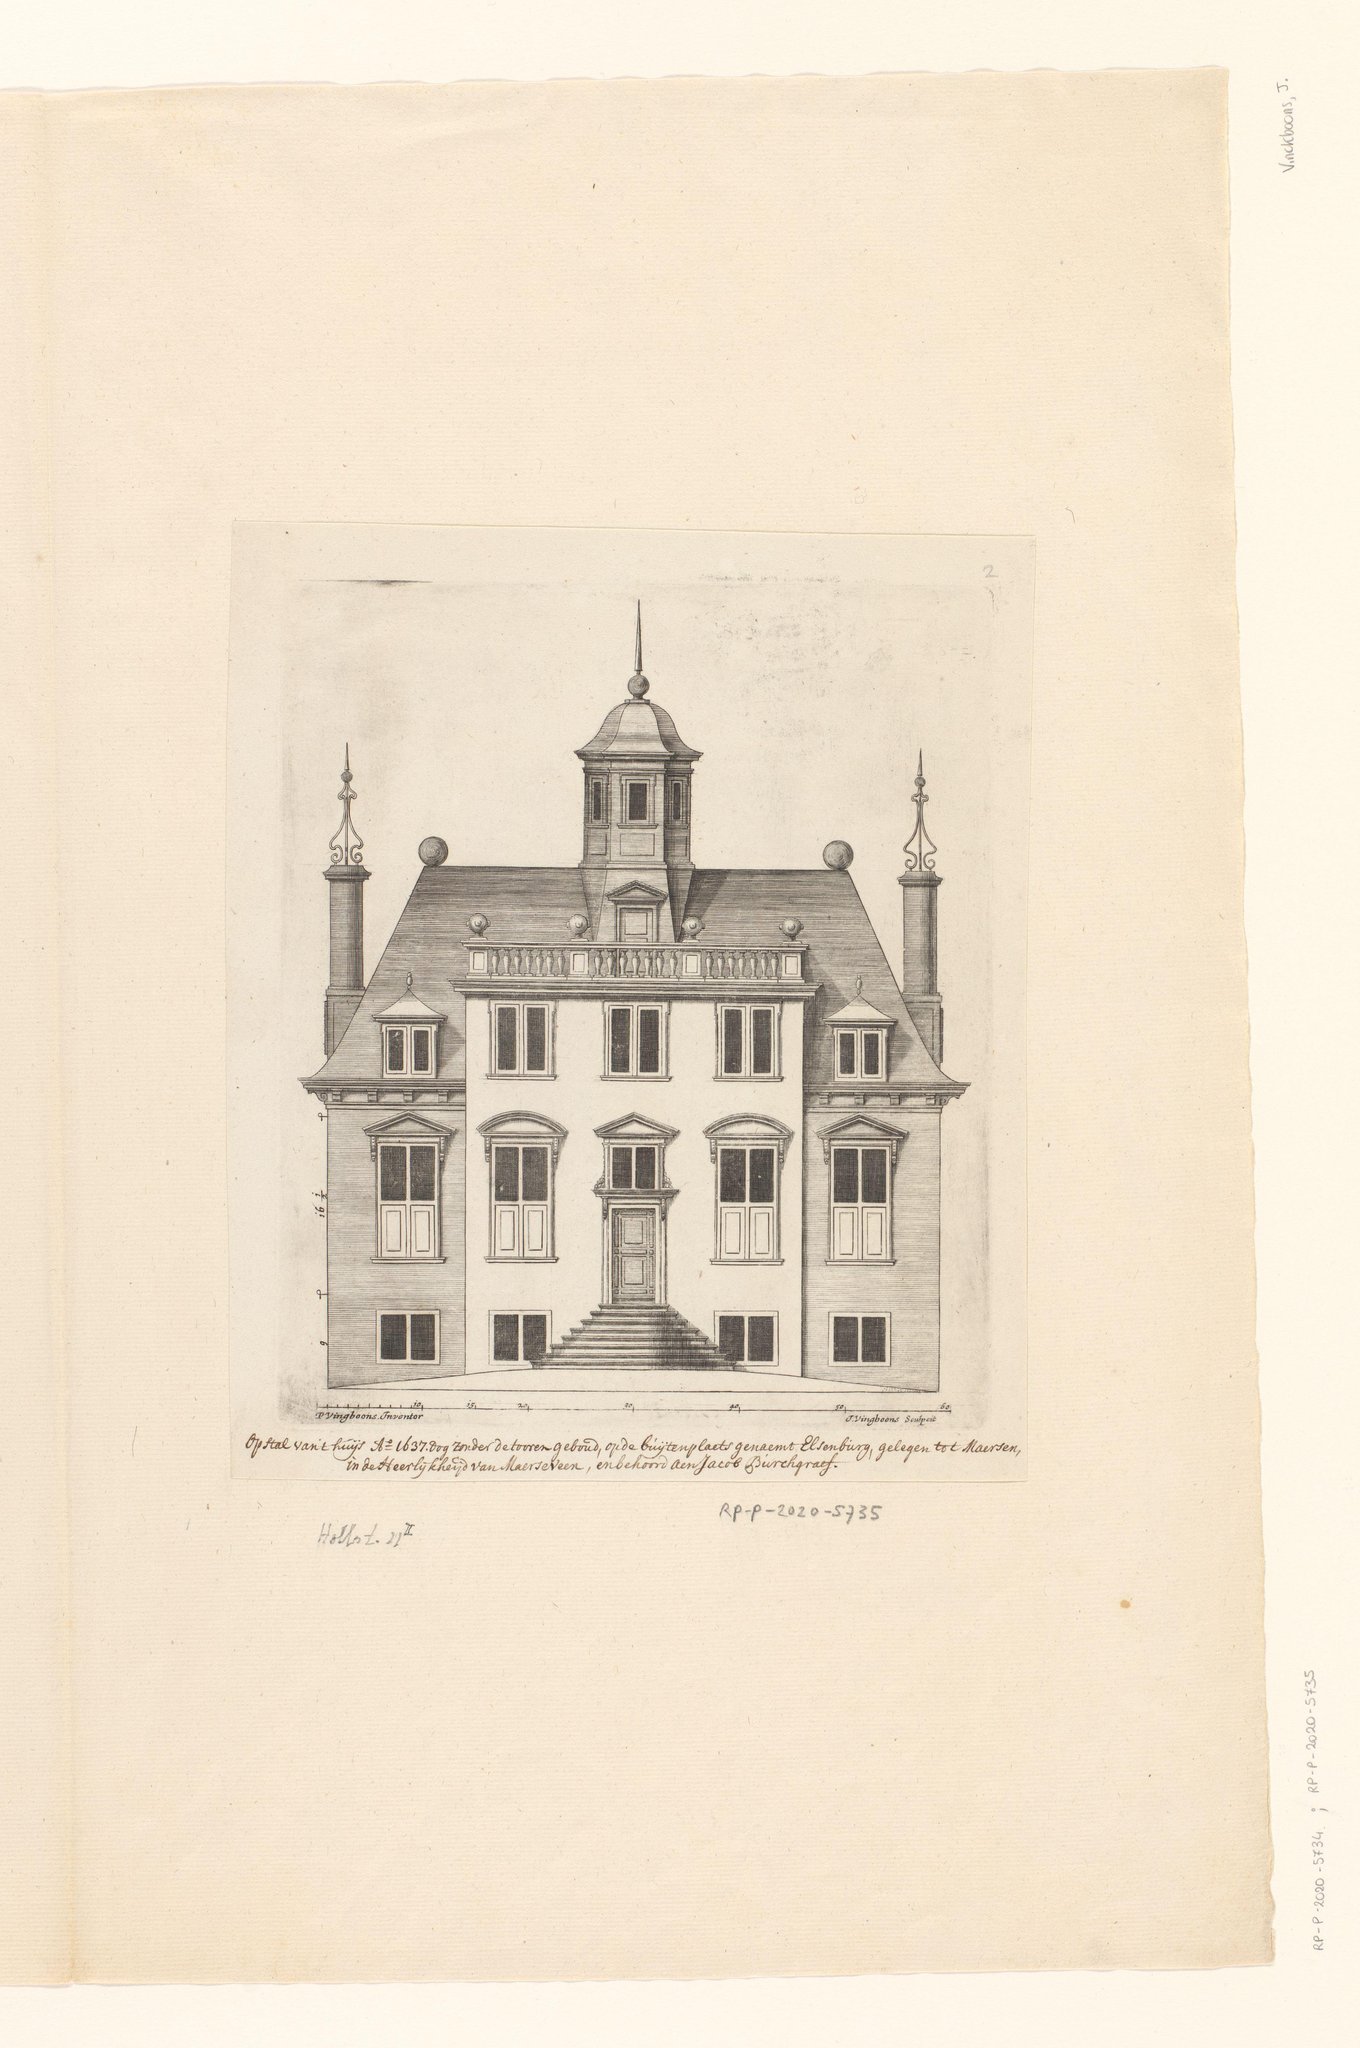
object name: print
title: Gevel van het landhuis Elsenburg te Maarsseveen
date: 1648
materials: paper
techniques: etching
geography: amsterdam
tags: country-house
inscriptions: inscription: ‘Opstal van 't huijs Ao. 1637. dog zonder de tooren geboud, op de buijtenplaets genaemt Elsenburg, gelegen tot Maersen,/ in de Heerlijkheijd van Maerseveen, en behoord aen Jacob Burchgraef.’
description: Prent waarschijnlijk uit: Afbeelsels der voornaemste gebouwen uyt alle die Philips Vingboons geordineert heeft. Amsterdam: Philips en Johannes Vinckboons en Johannes Willemszoon Blaeu, 1648. Deze prent is geplakt op een albumblad, dat vast zit aan een ander albumblad. Op het eerste albumblad is RP-P-2020-5734 geplakt.